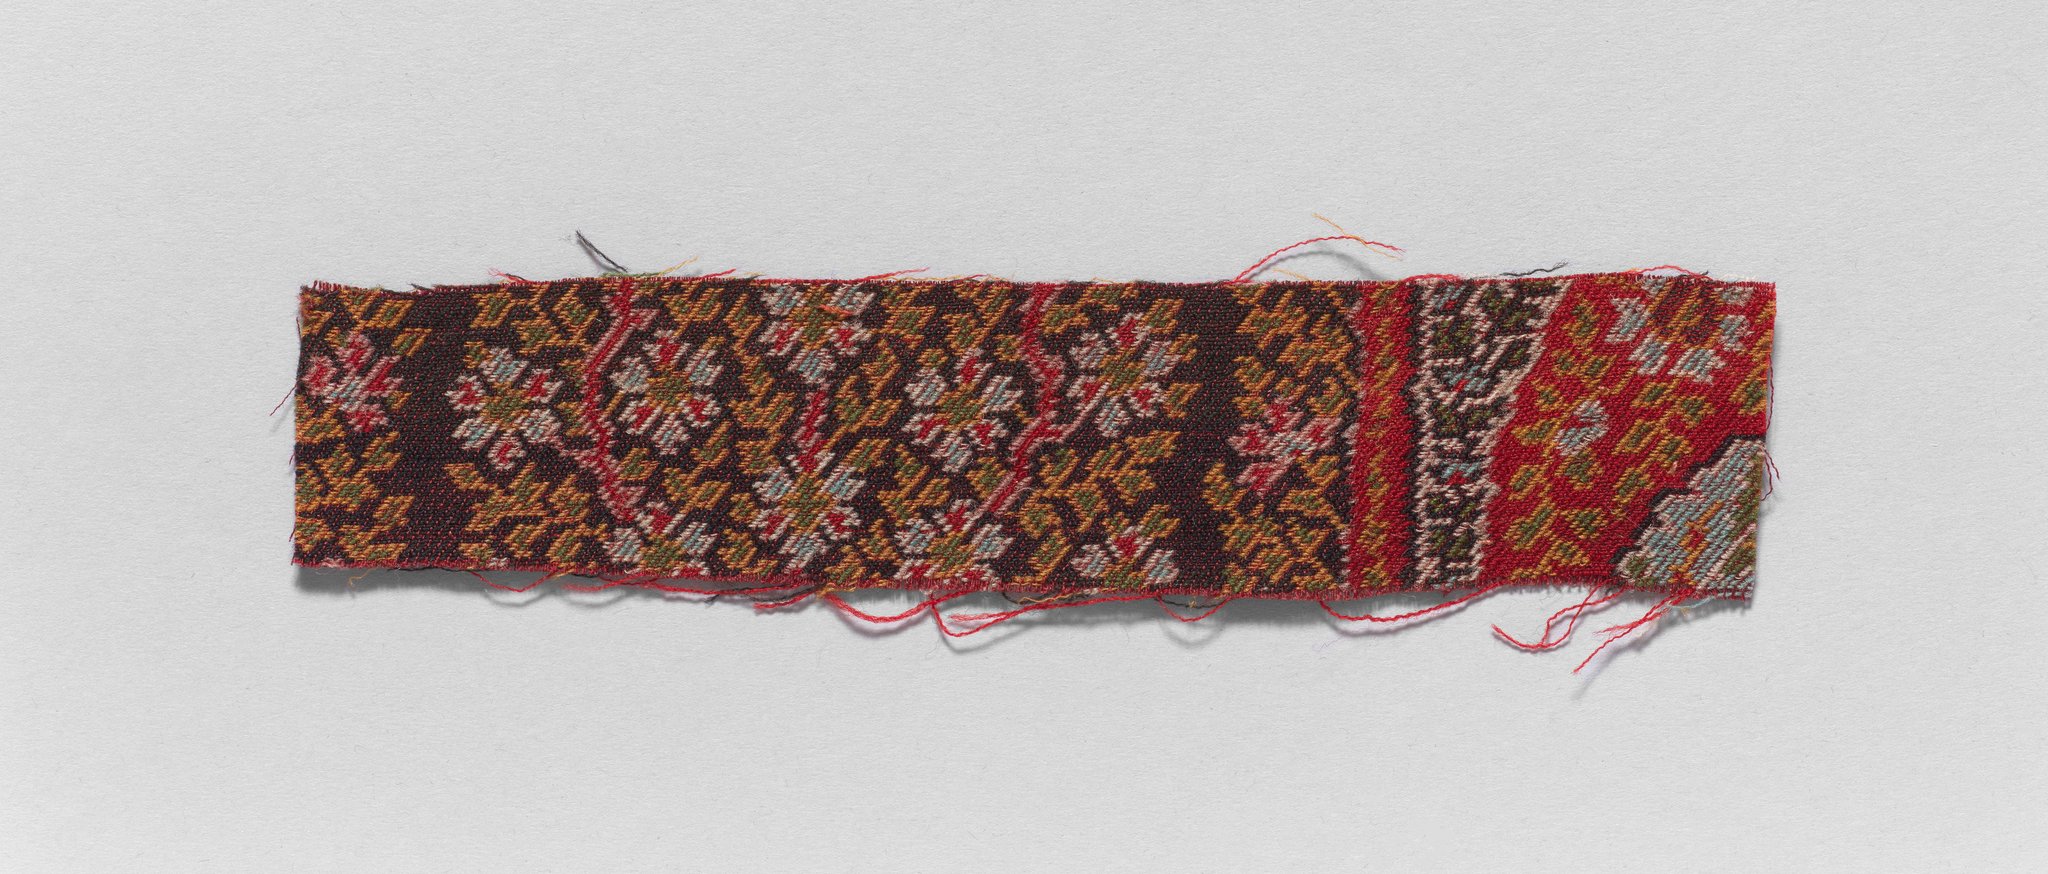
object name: piece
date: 1801-1900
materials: wool